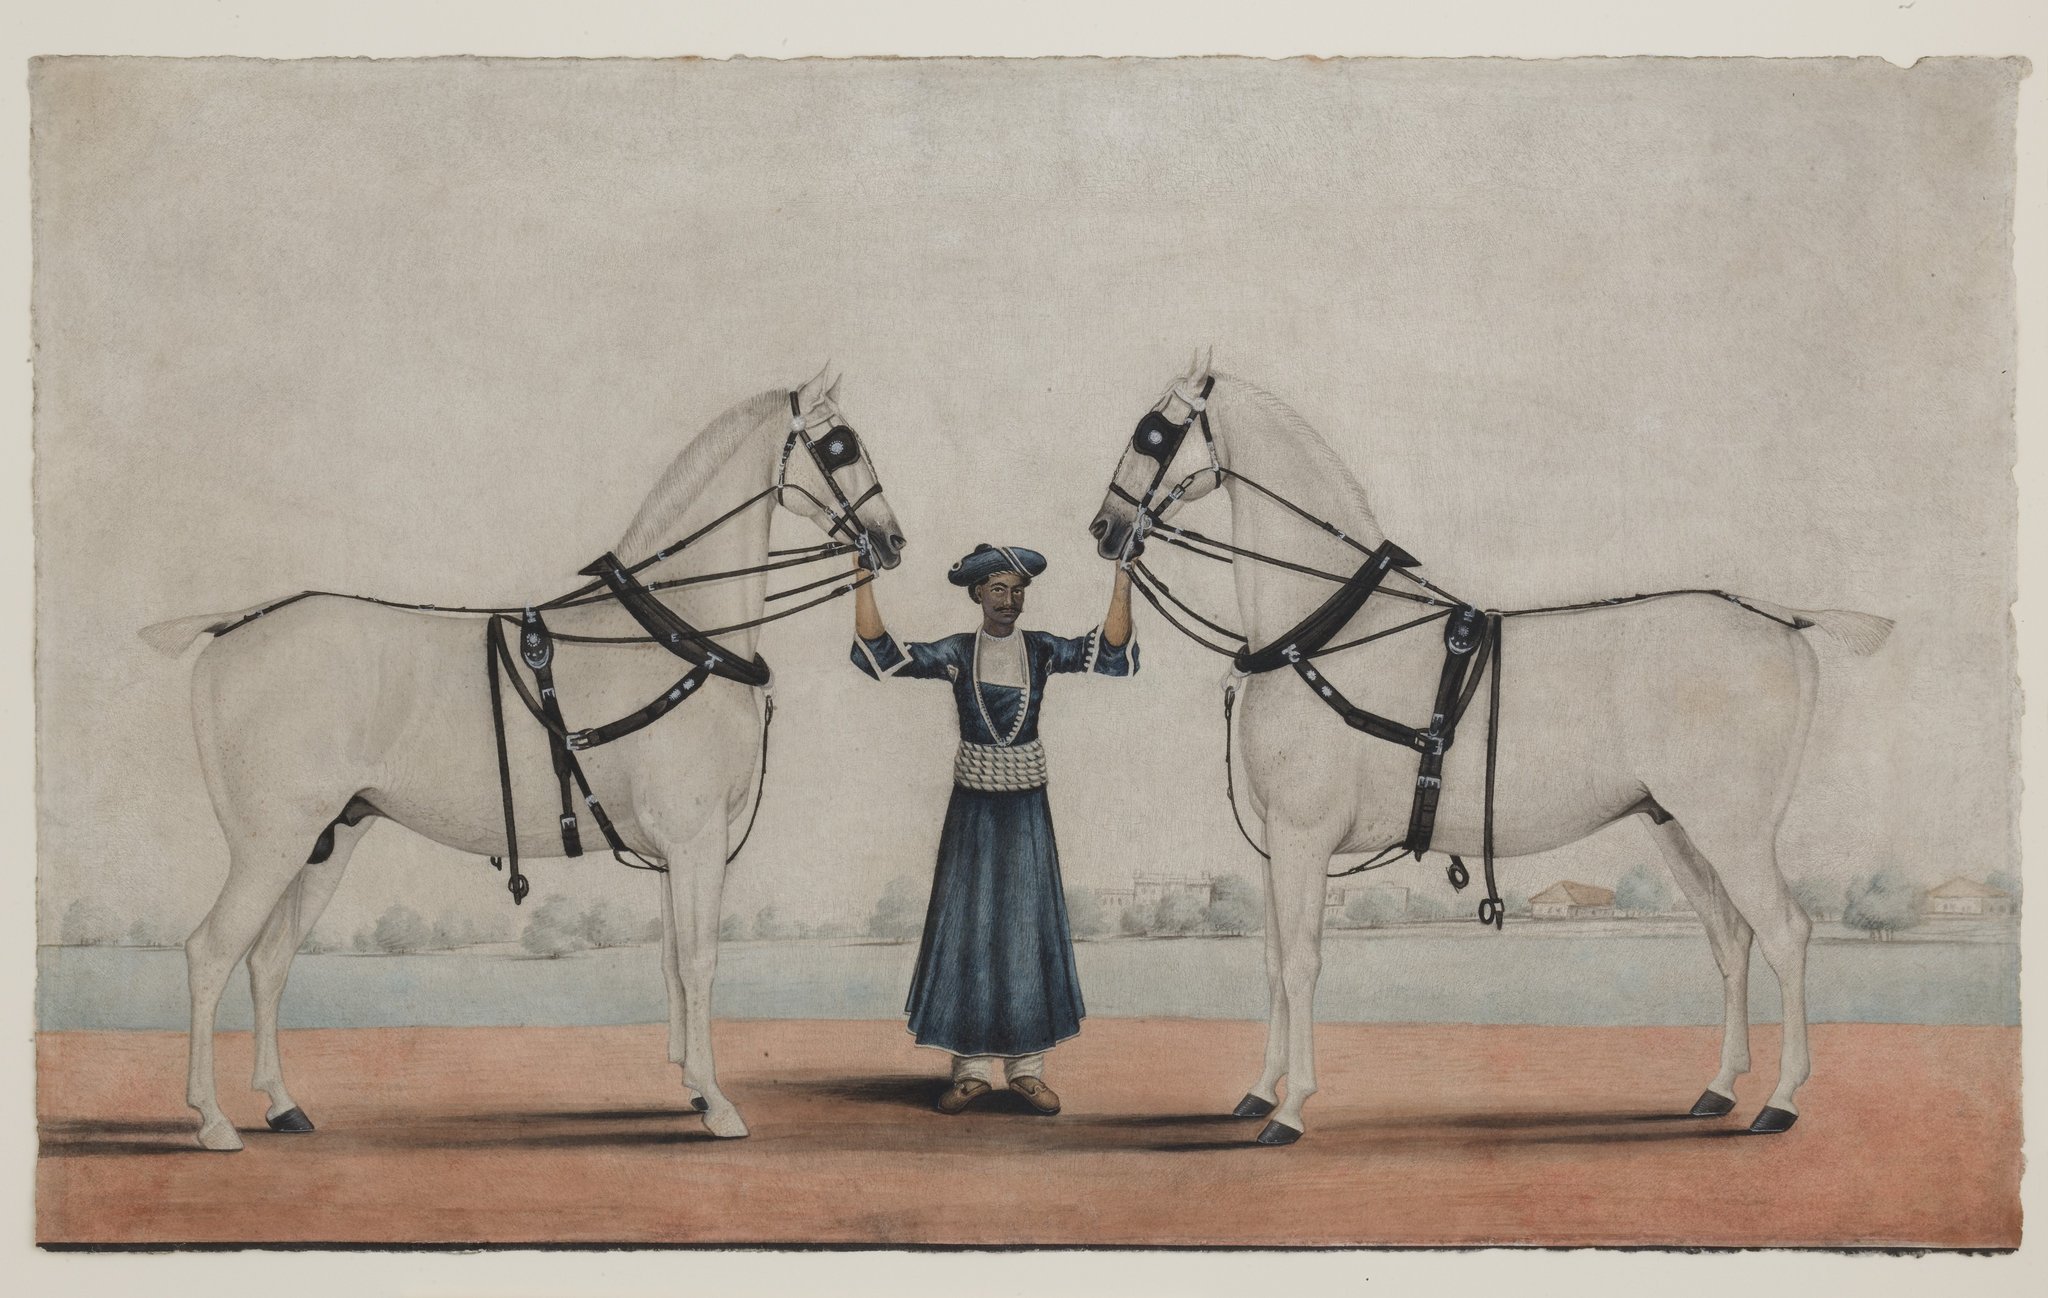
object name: illustrated single work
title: A Syce (Groom) Holding Two Carriage Horses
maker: shaikh muhammad amir of karraya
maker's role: artist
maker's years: 1830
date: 1845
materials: paper, watercolor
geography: india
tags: men,horses